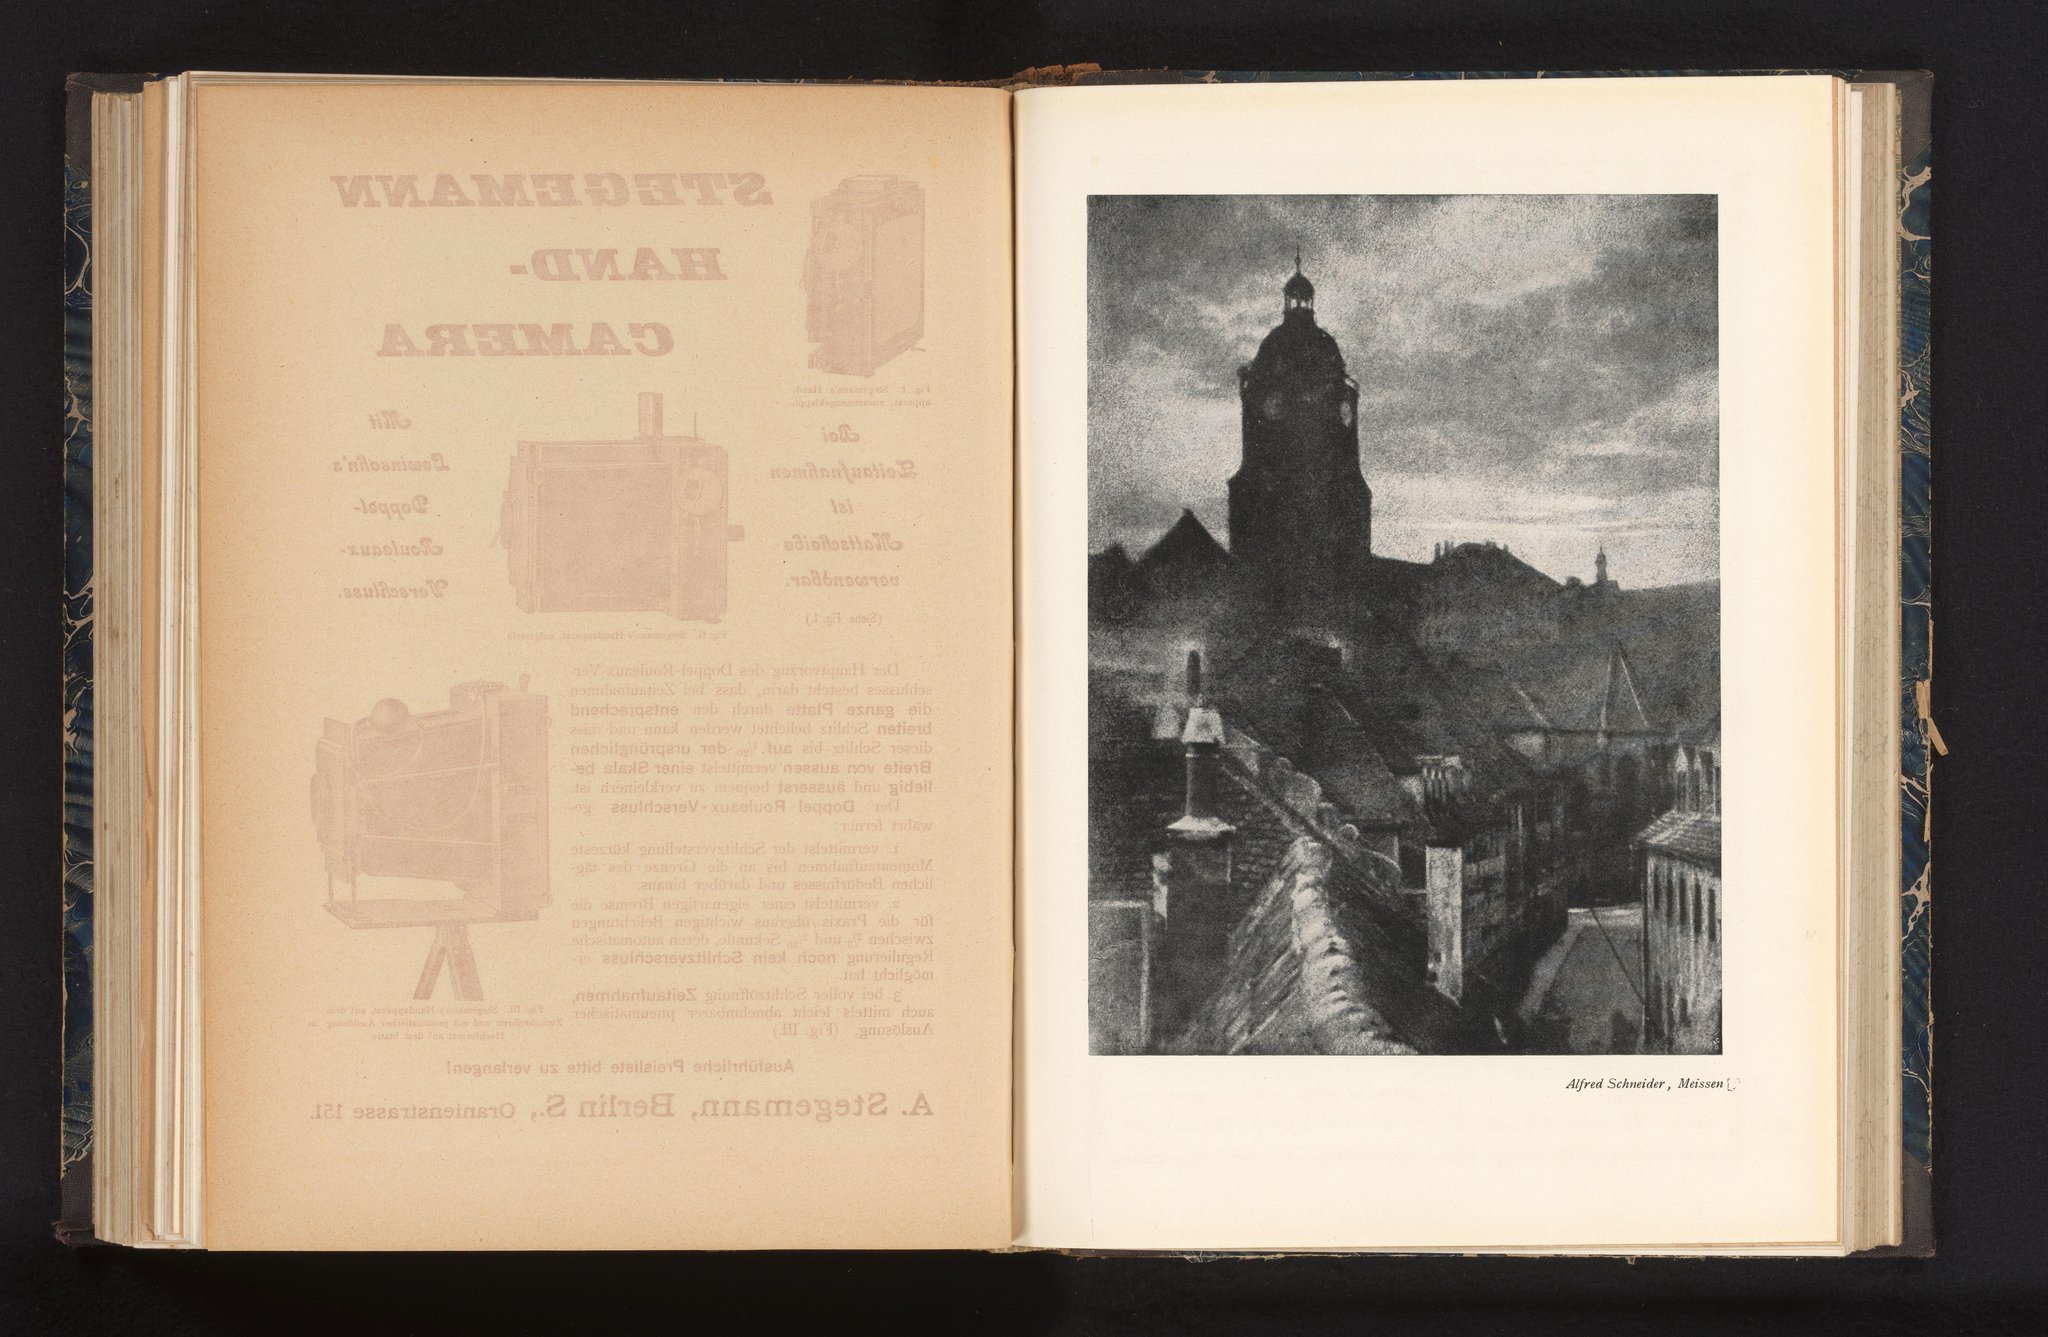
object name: photomechanical print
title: Gezicht op de daken van een dorp of stad en een kerktoren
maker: alfred schneider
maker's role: fotograaf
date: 1897-1902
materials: paper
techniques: autotype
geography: berlin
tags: roof (of house or building)